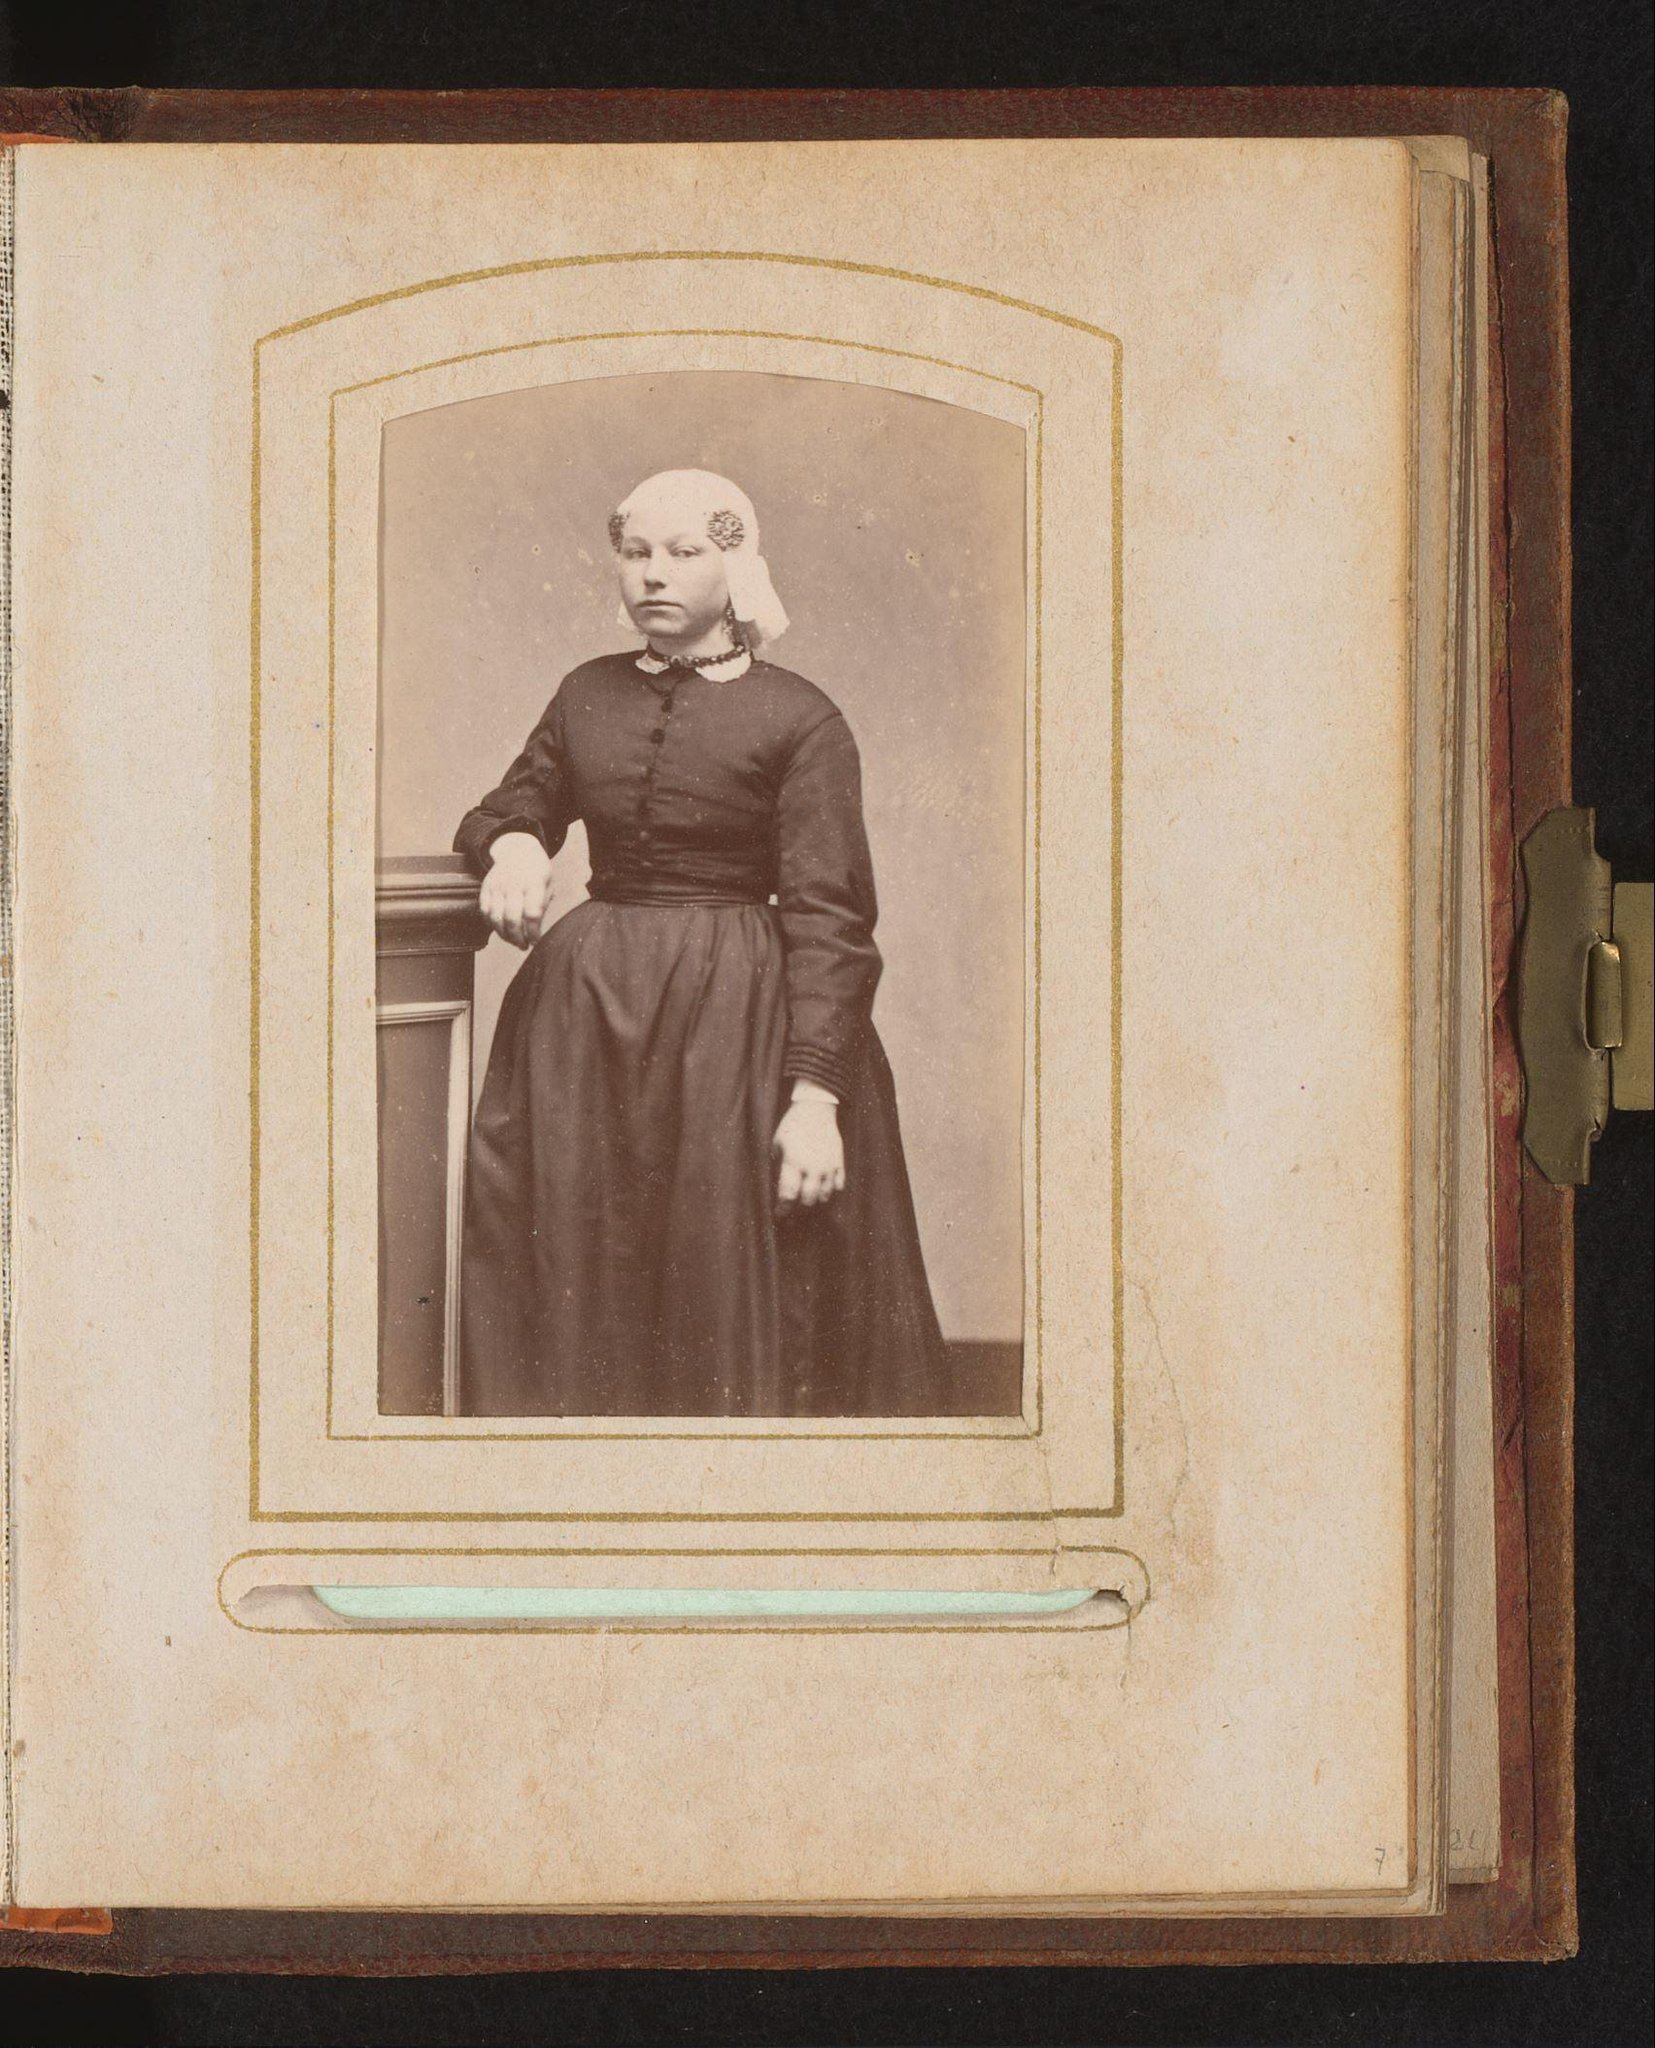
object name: photograph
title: Portret van een jonge vrouw in klederdracht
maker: Anonymous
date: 1850-1890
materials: cardboard, photographic support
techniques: albumen print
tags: adolescent, young woman, maiden, historical persons, folk costume, regional costume